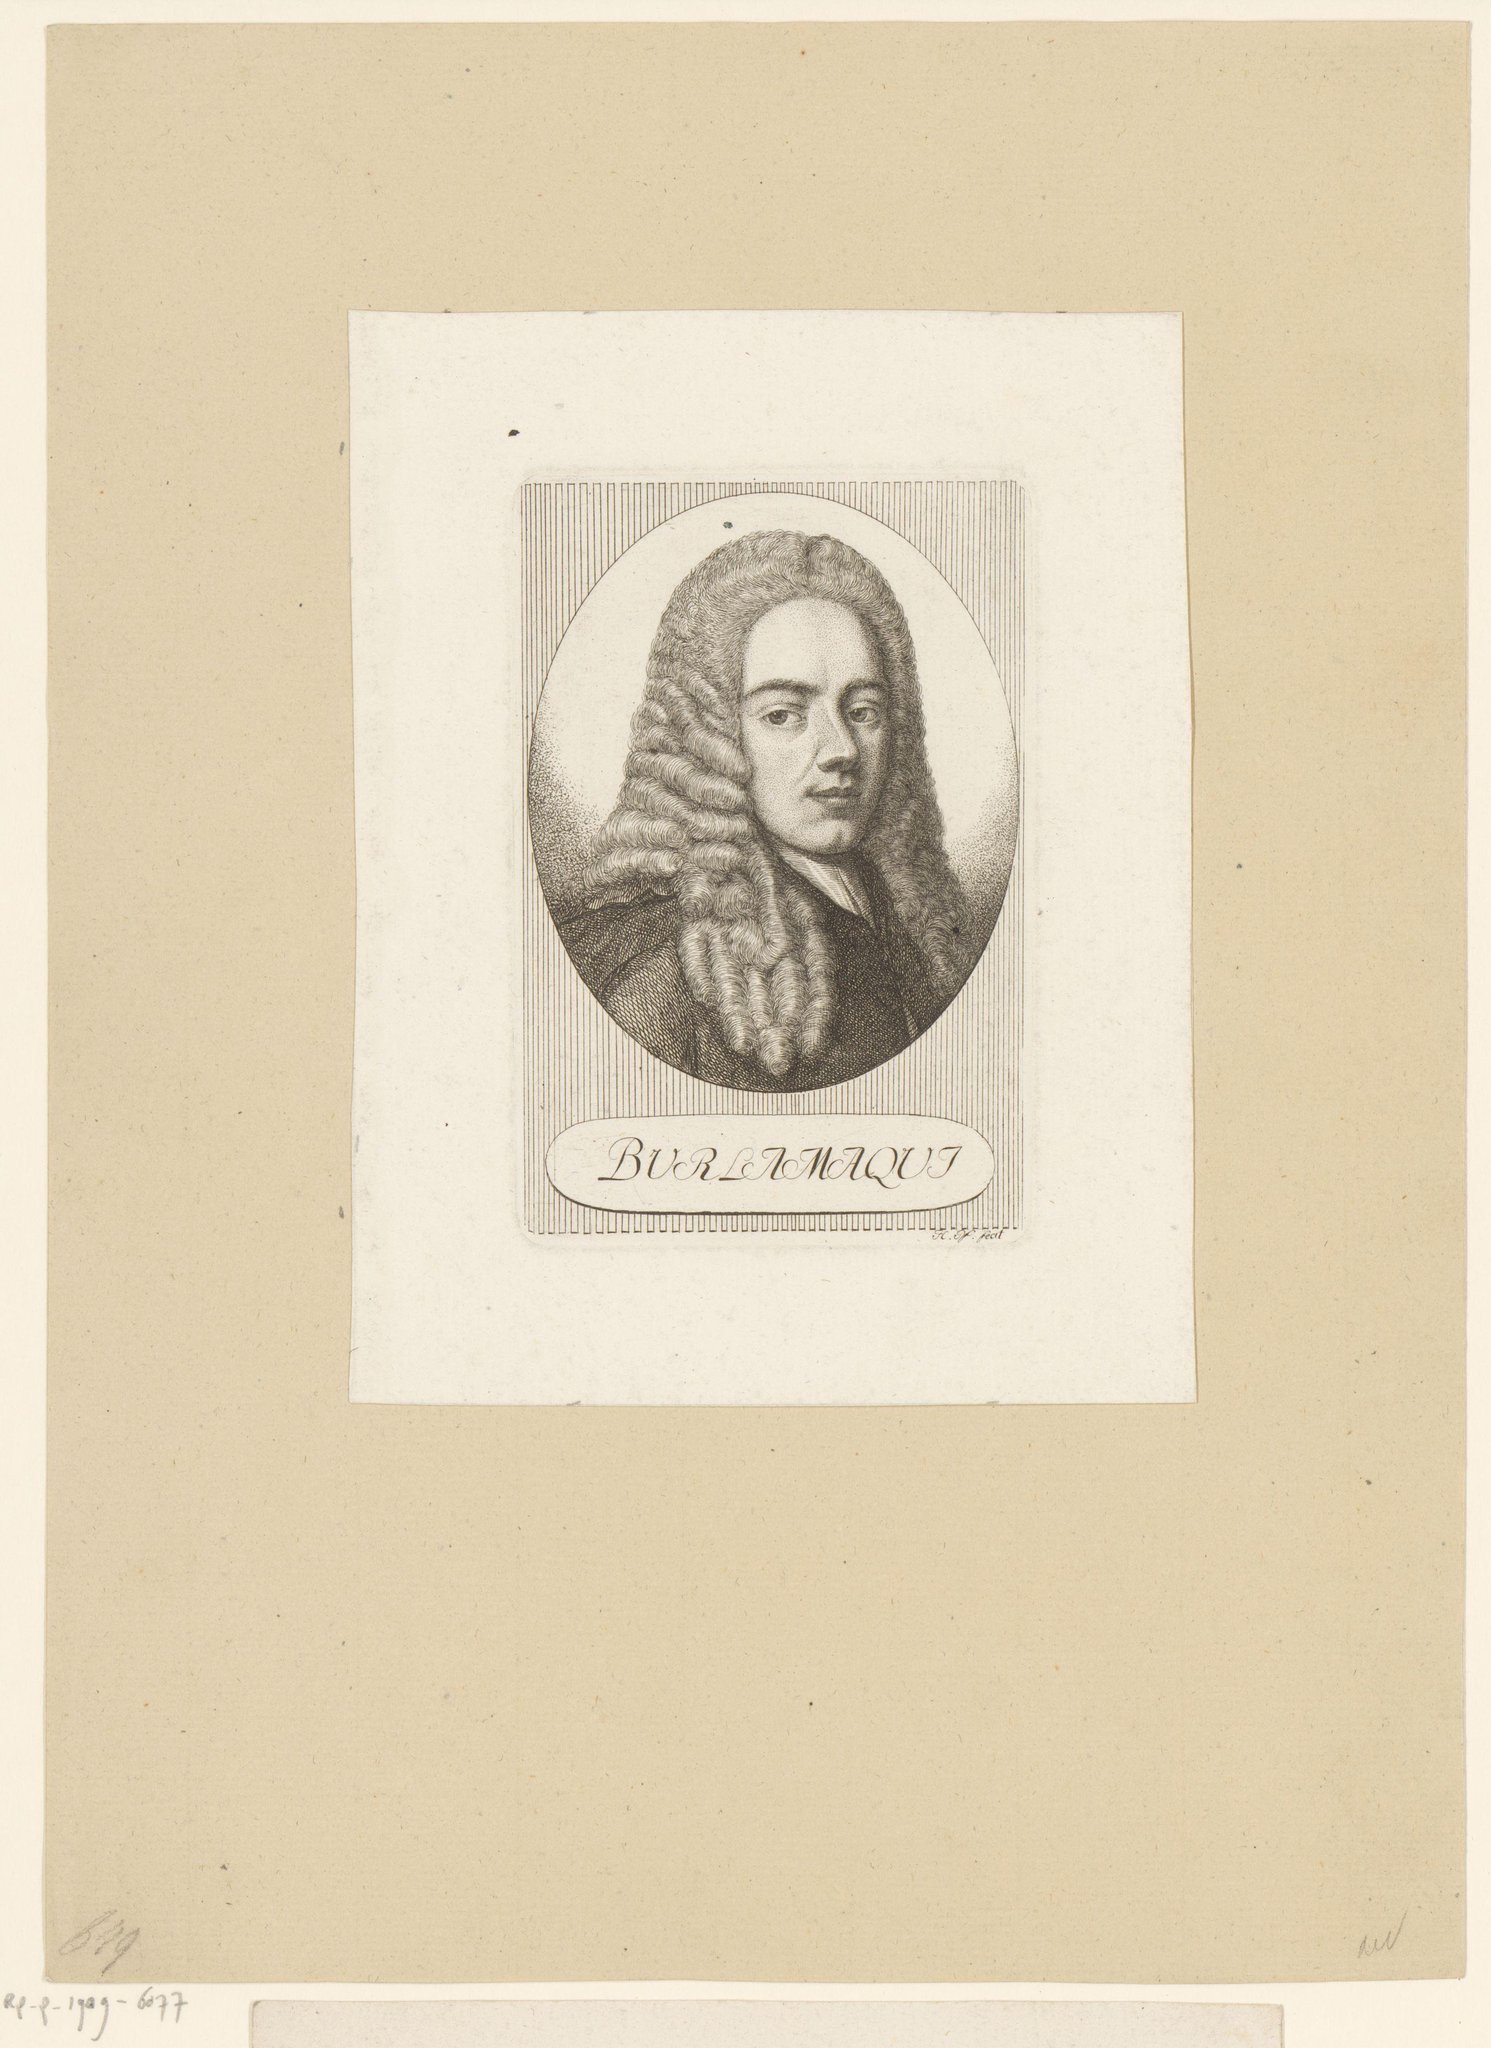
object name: print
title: Portret van Jean-Jacques Burlamaqui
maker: heinrich pfenninger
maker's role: print maker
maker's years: 1749-1815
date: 1759-1815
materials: paper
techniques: etching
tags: historical persons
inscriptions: collector's mark: Lugt 2228